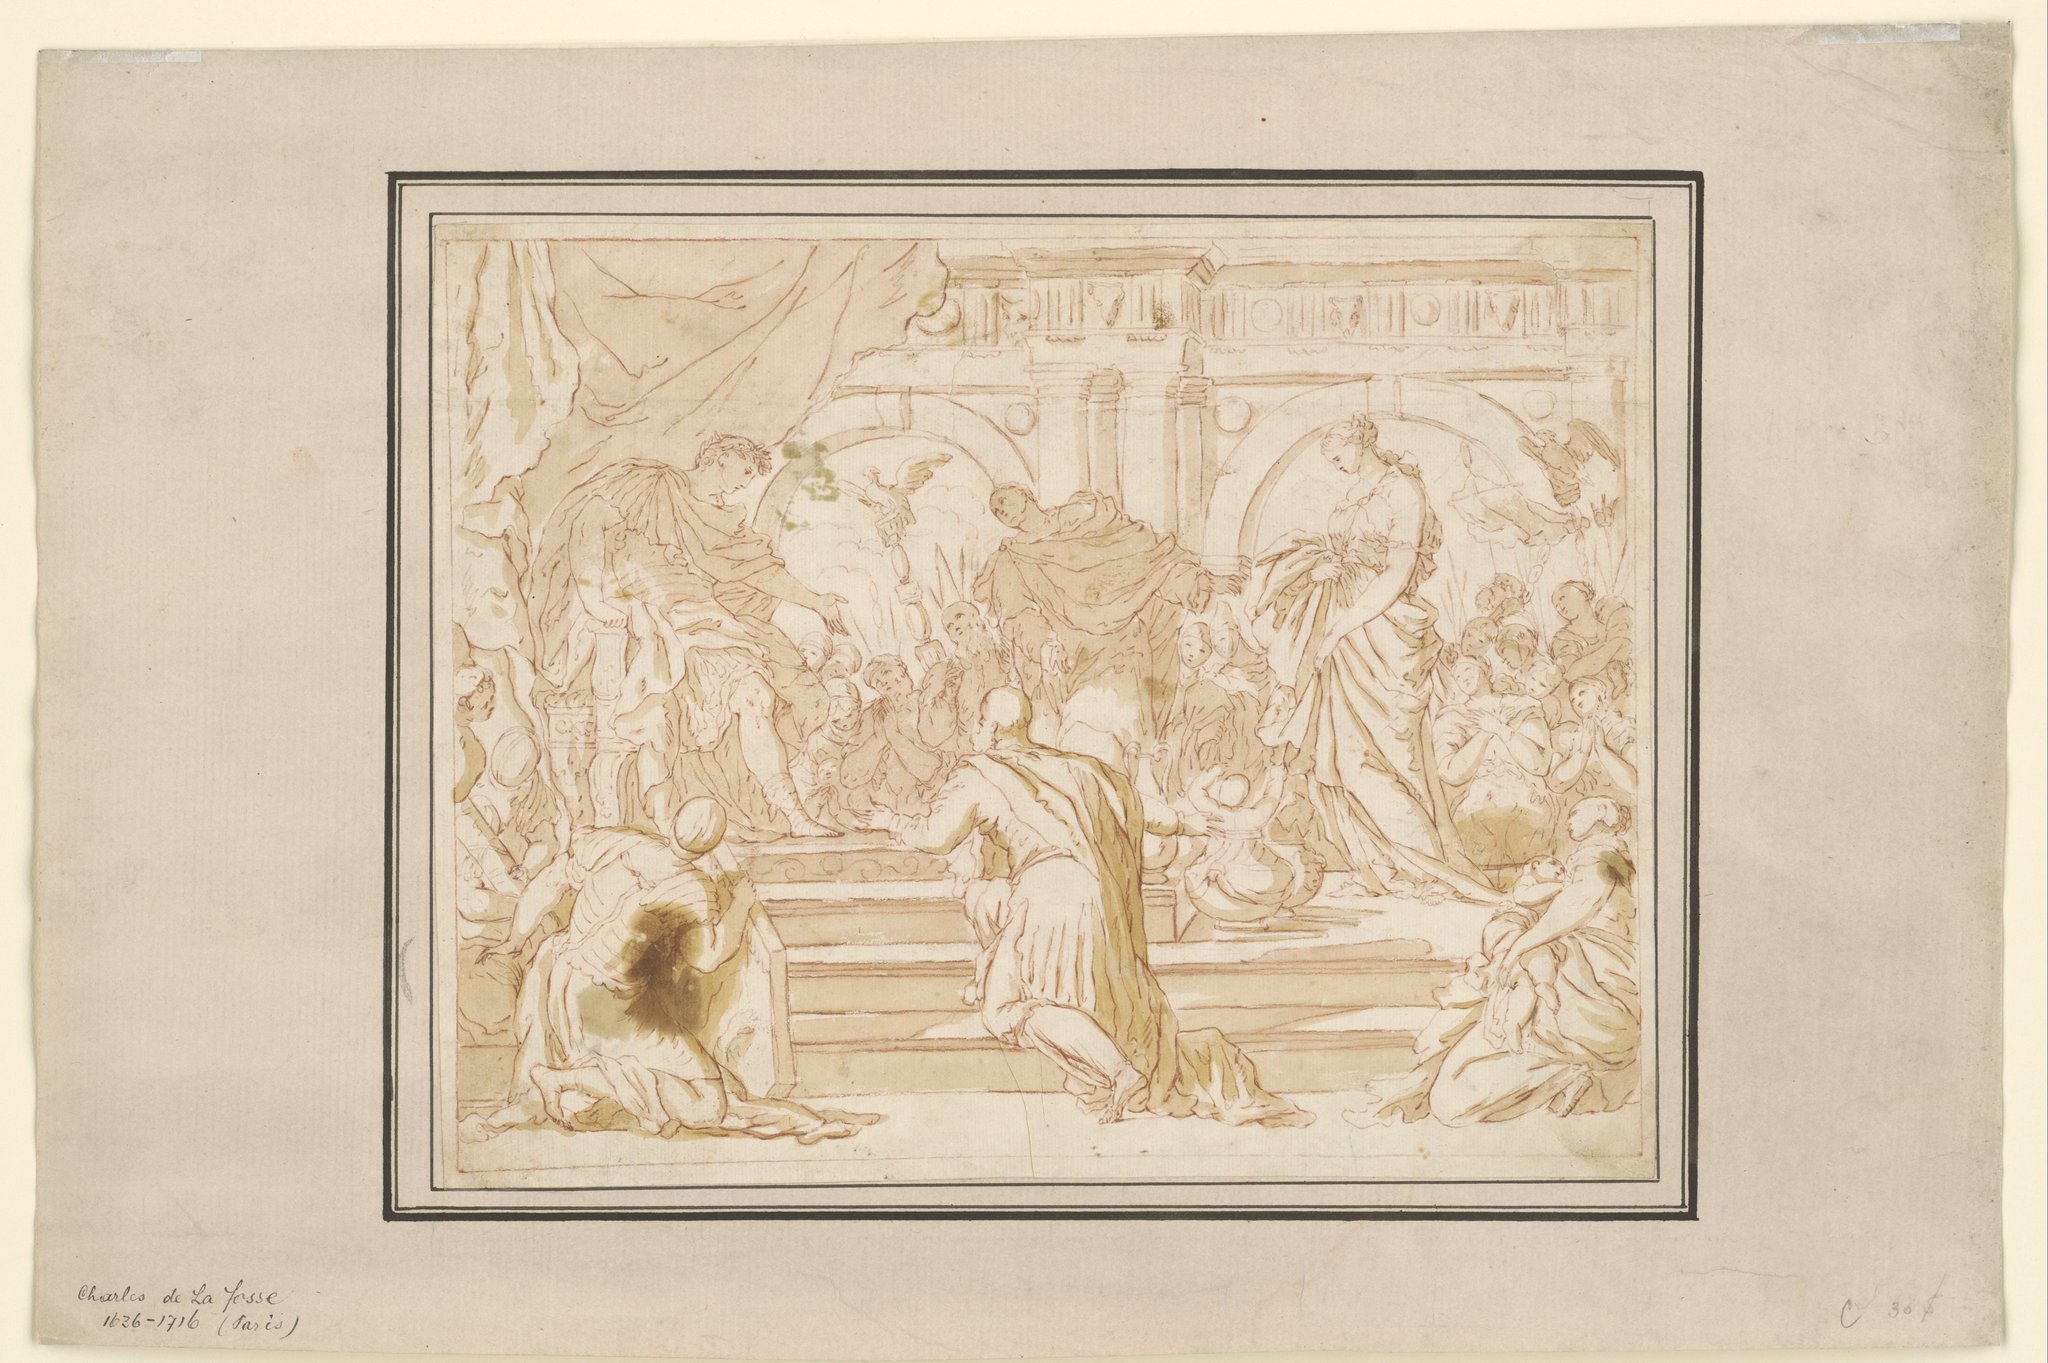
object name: drawing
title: De grootmoedigheid van Scipio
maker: charles de lafosse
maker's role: draughtsman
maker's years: 1636-1716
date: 1650-1716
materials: chalk, paper, pencil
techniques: brush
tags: the continence of scipio: he restores a captive woman to her bridegroom allucius, who kneels before him; the ransom offered by the bride's parents is given to allucius as a wedding-gift